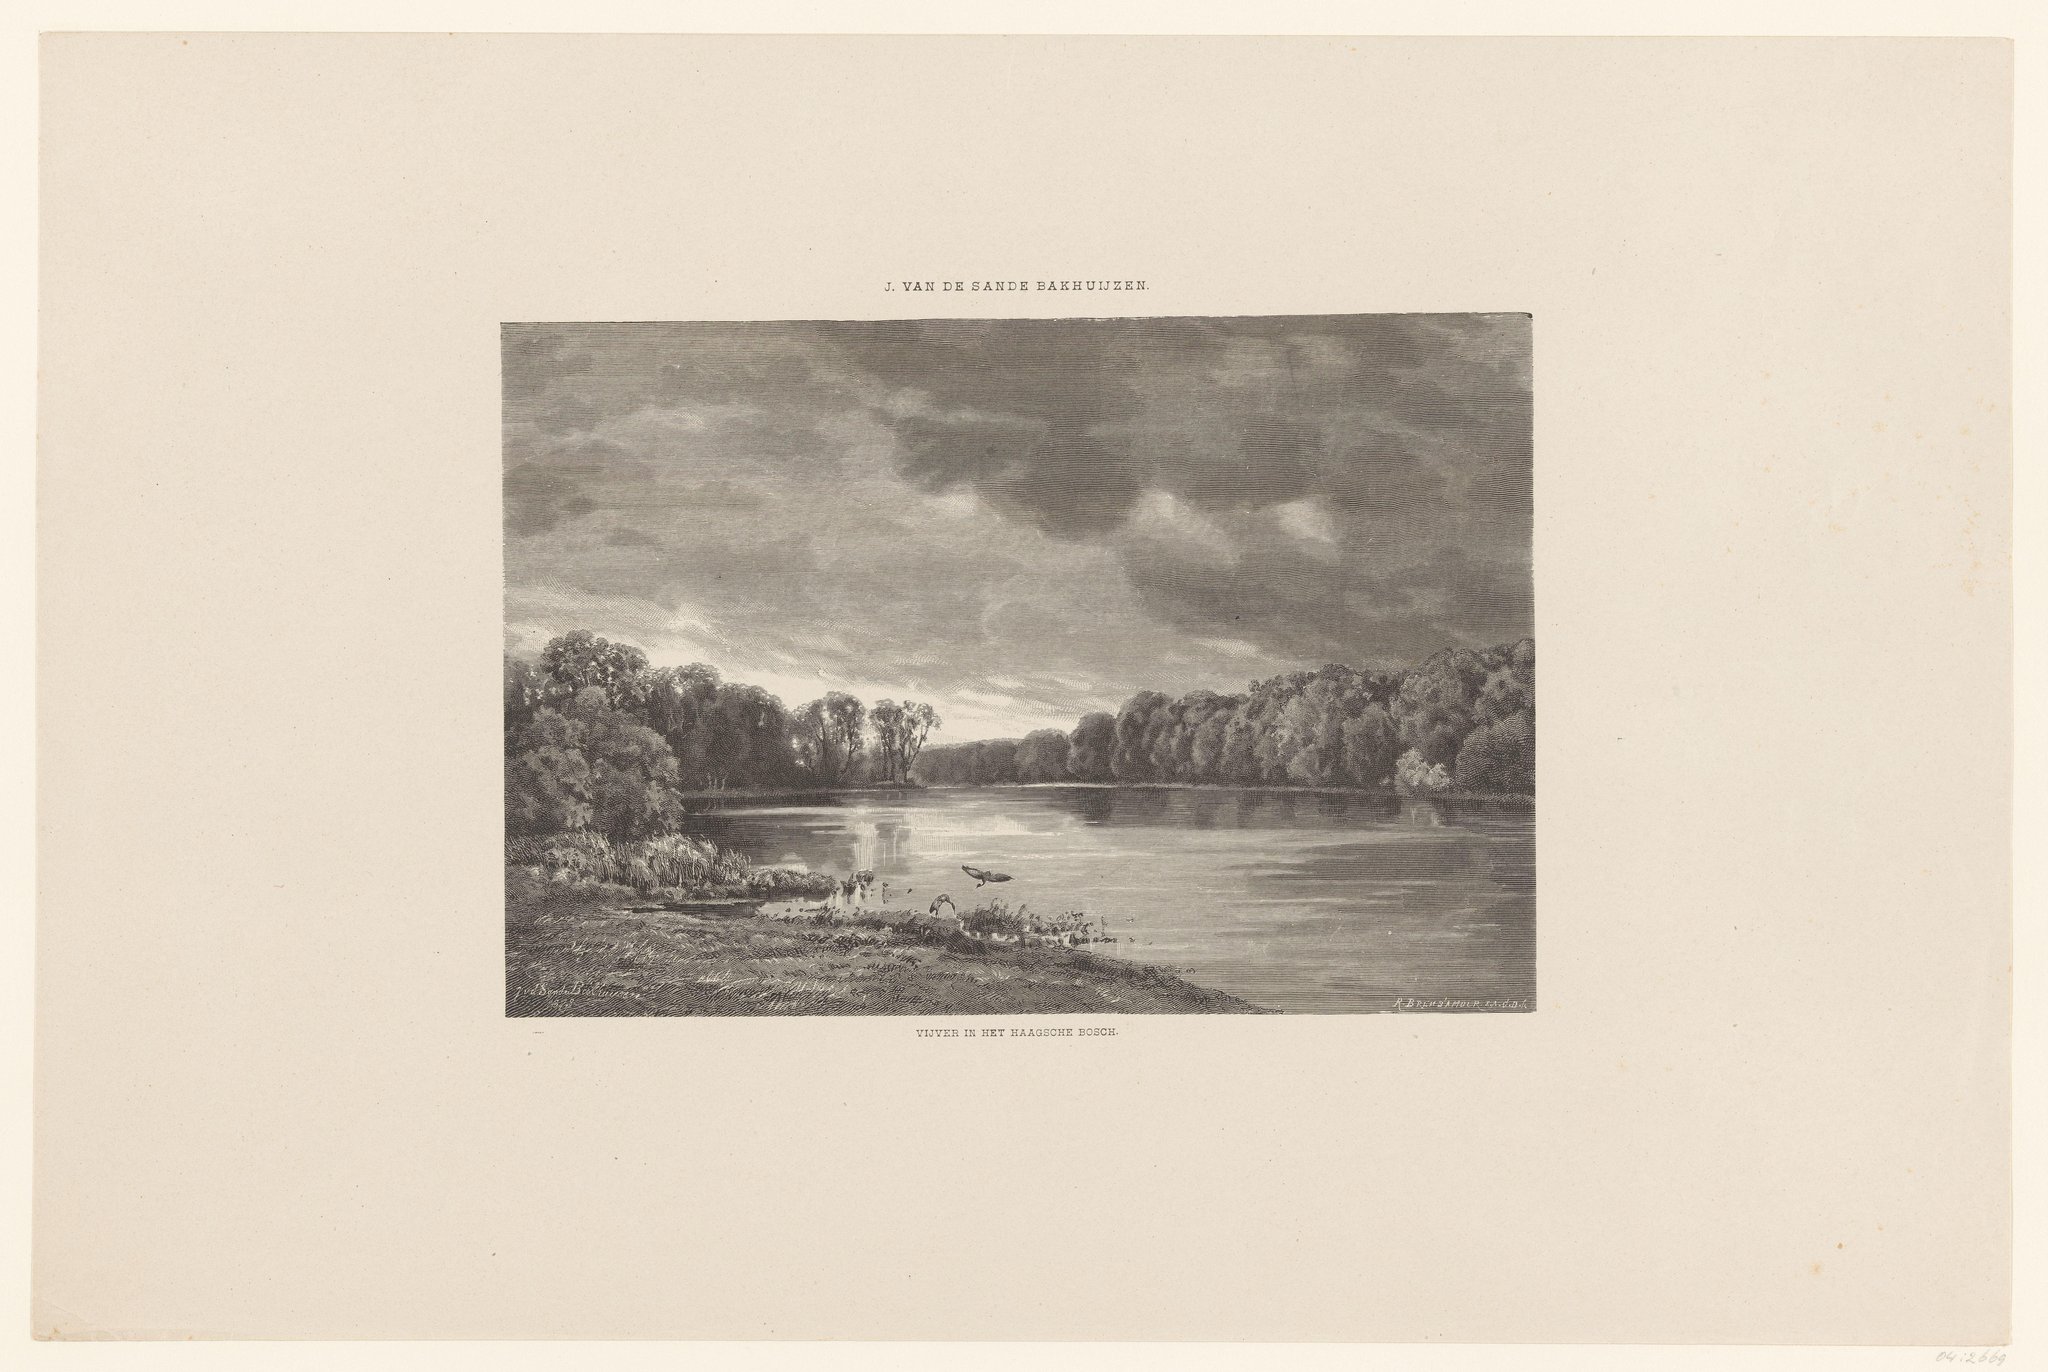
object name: print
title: Gezicht op de vijver van het Haagse Bos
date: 1841-1904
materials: paper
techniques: engraving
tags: park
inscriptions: collector's mark: Lugt 2228